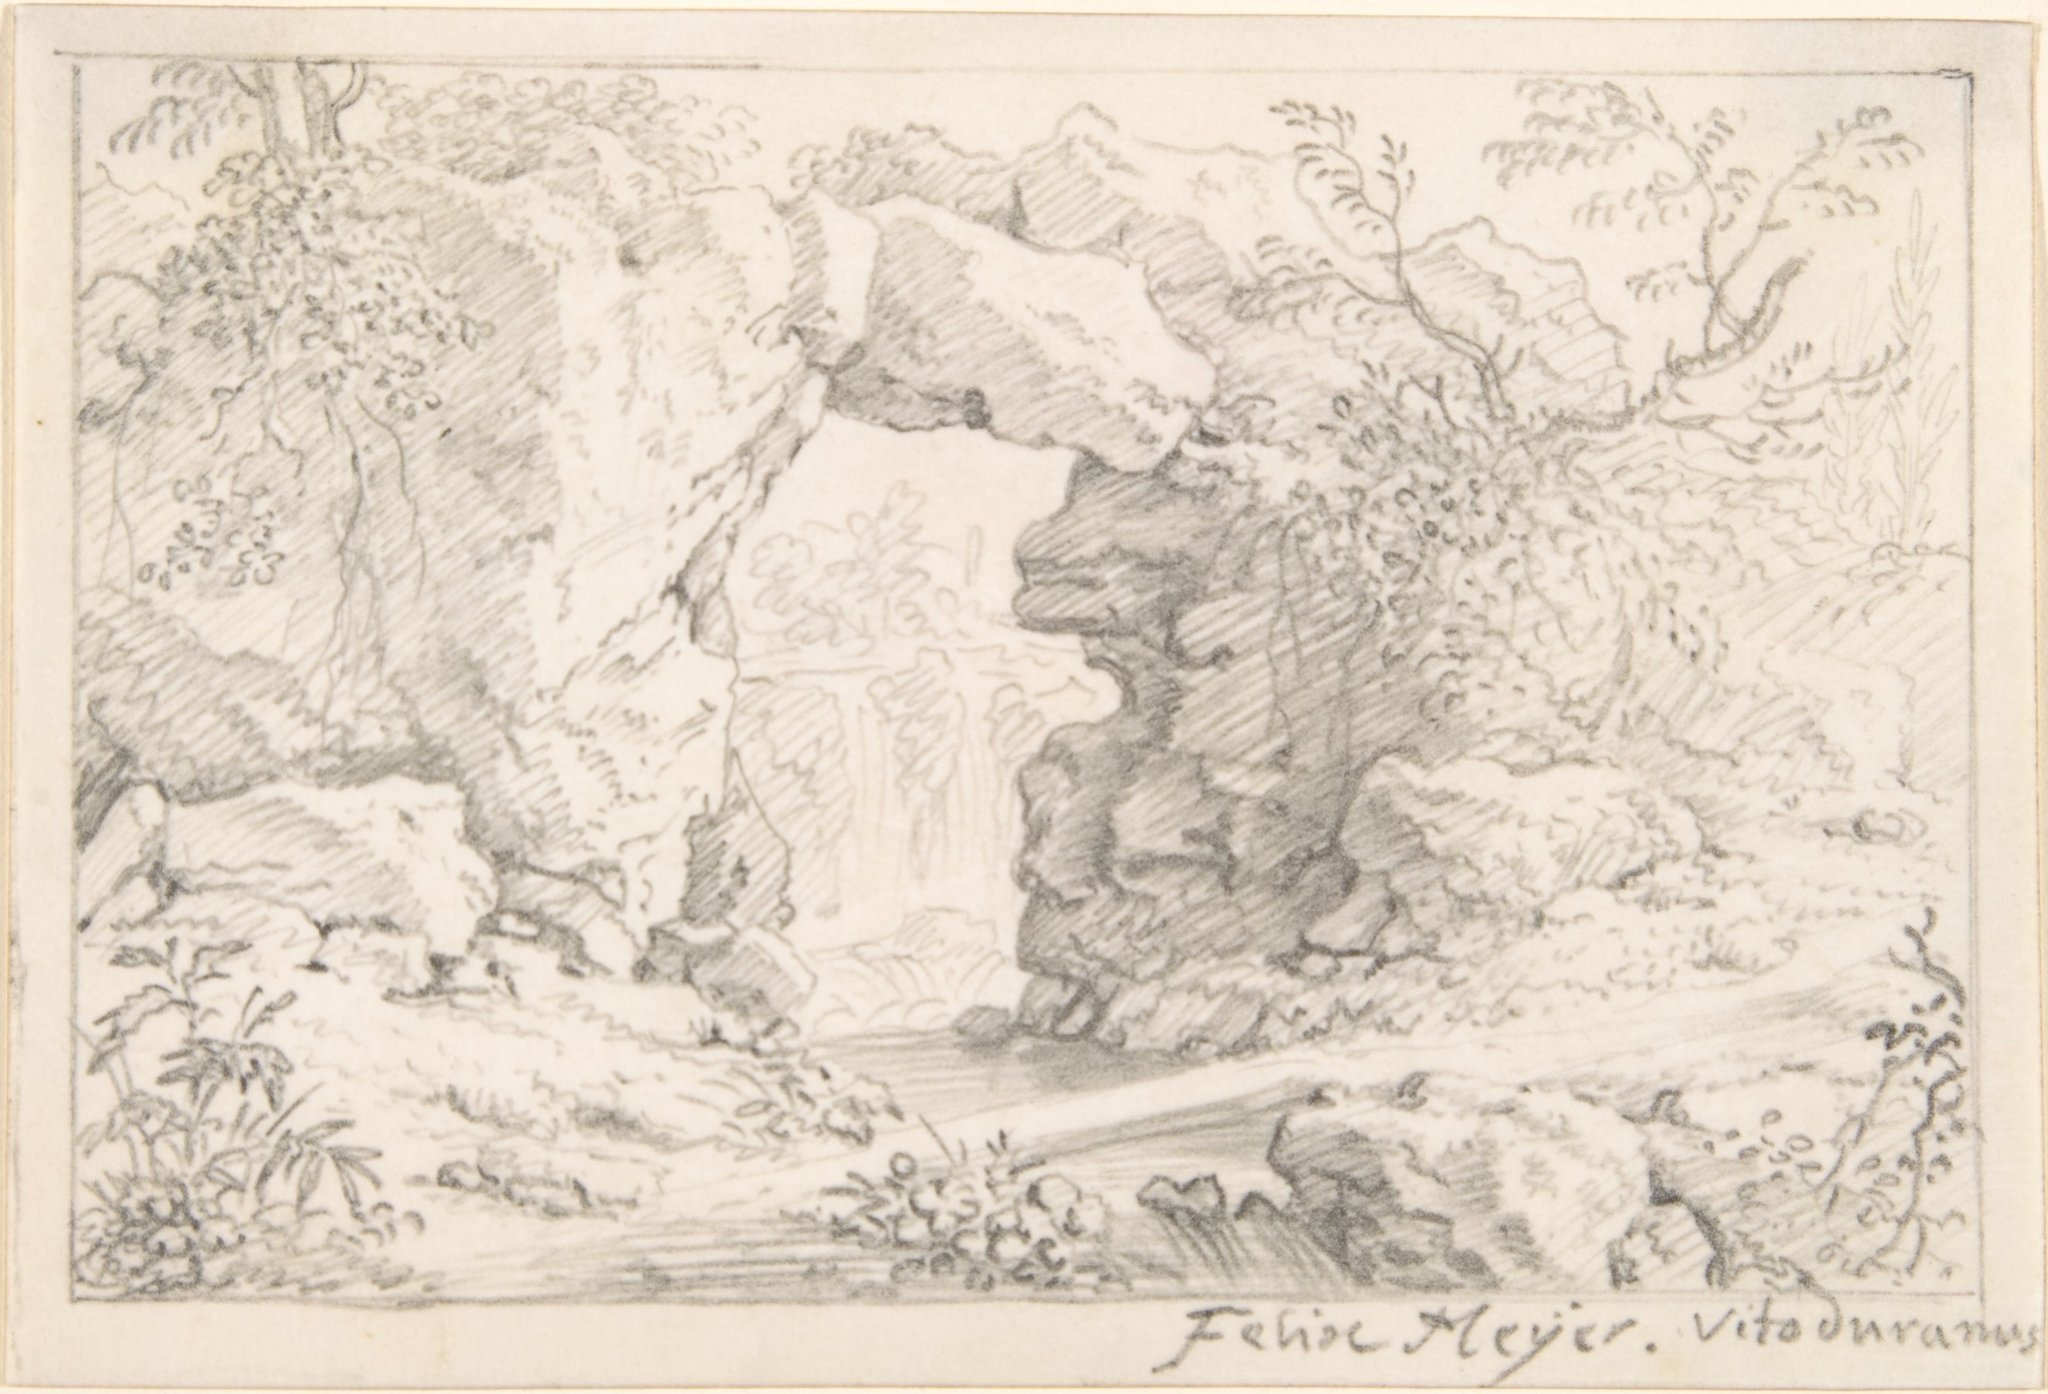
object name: drawing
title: Landscape with a Natural Arch and a Waterfall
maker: felix meyer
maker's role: artist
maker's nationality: swiss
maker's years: 1653-1713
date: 1601-1733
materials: graphite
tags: waterfalls,landscapes,trees